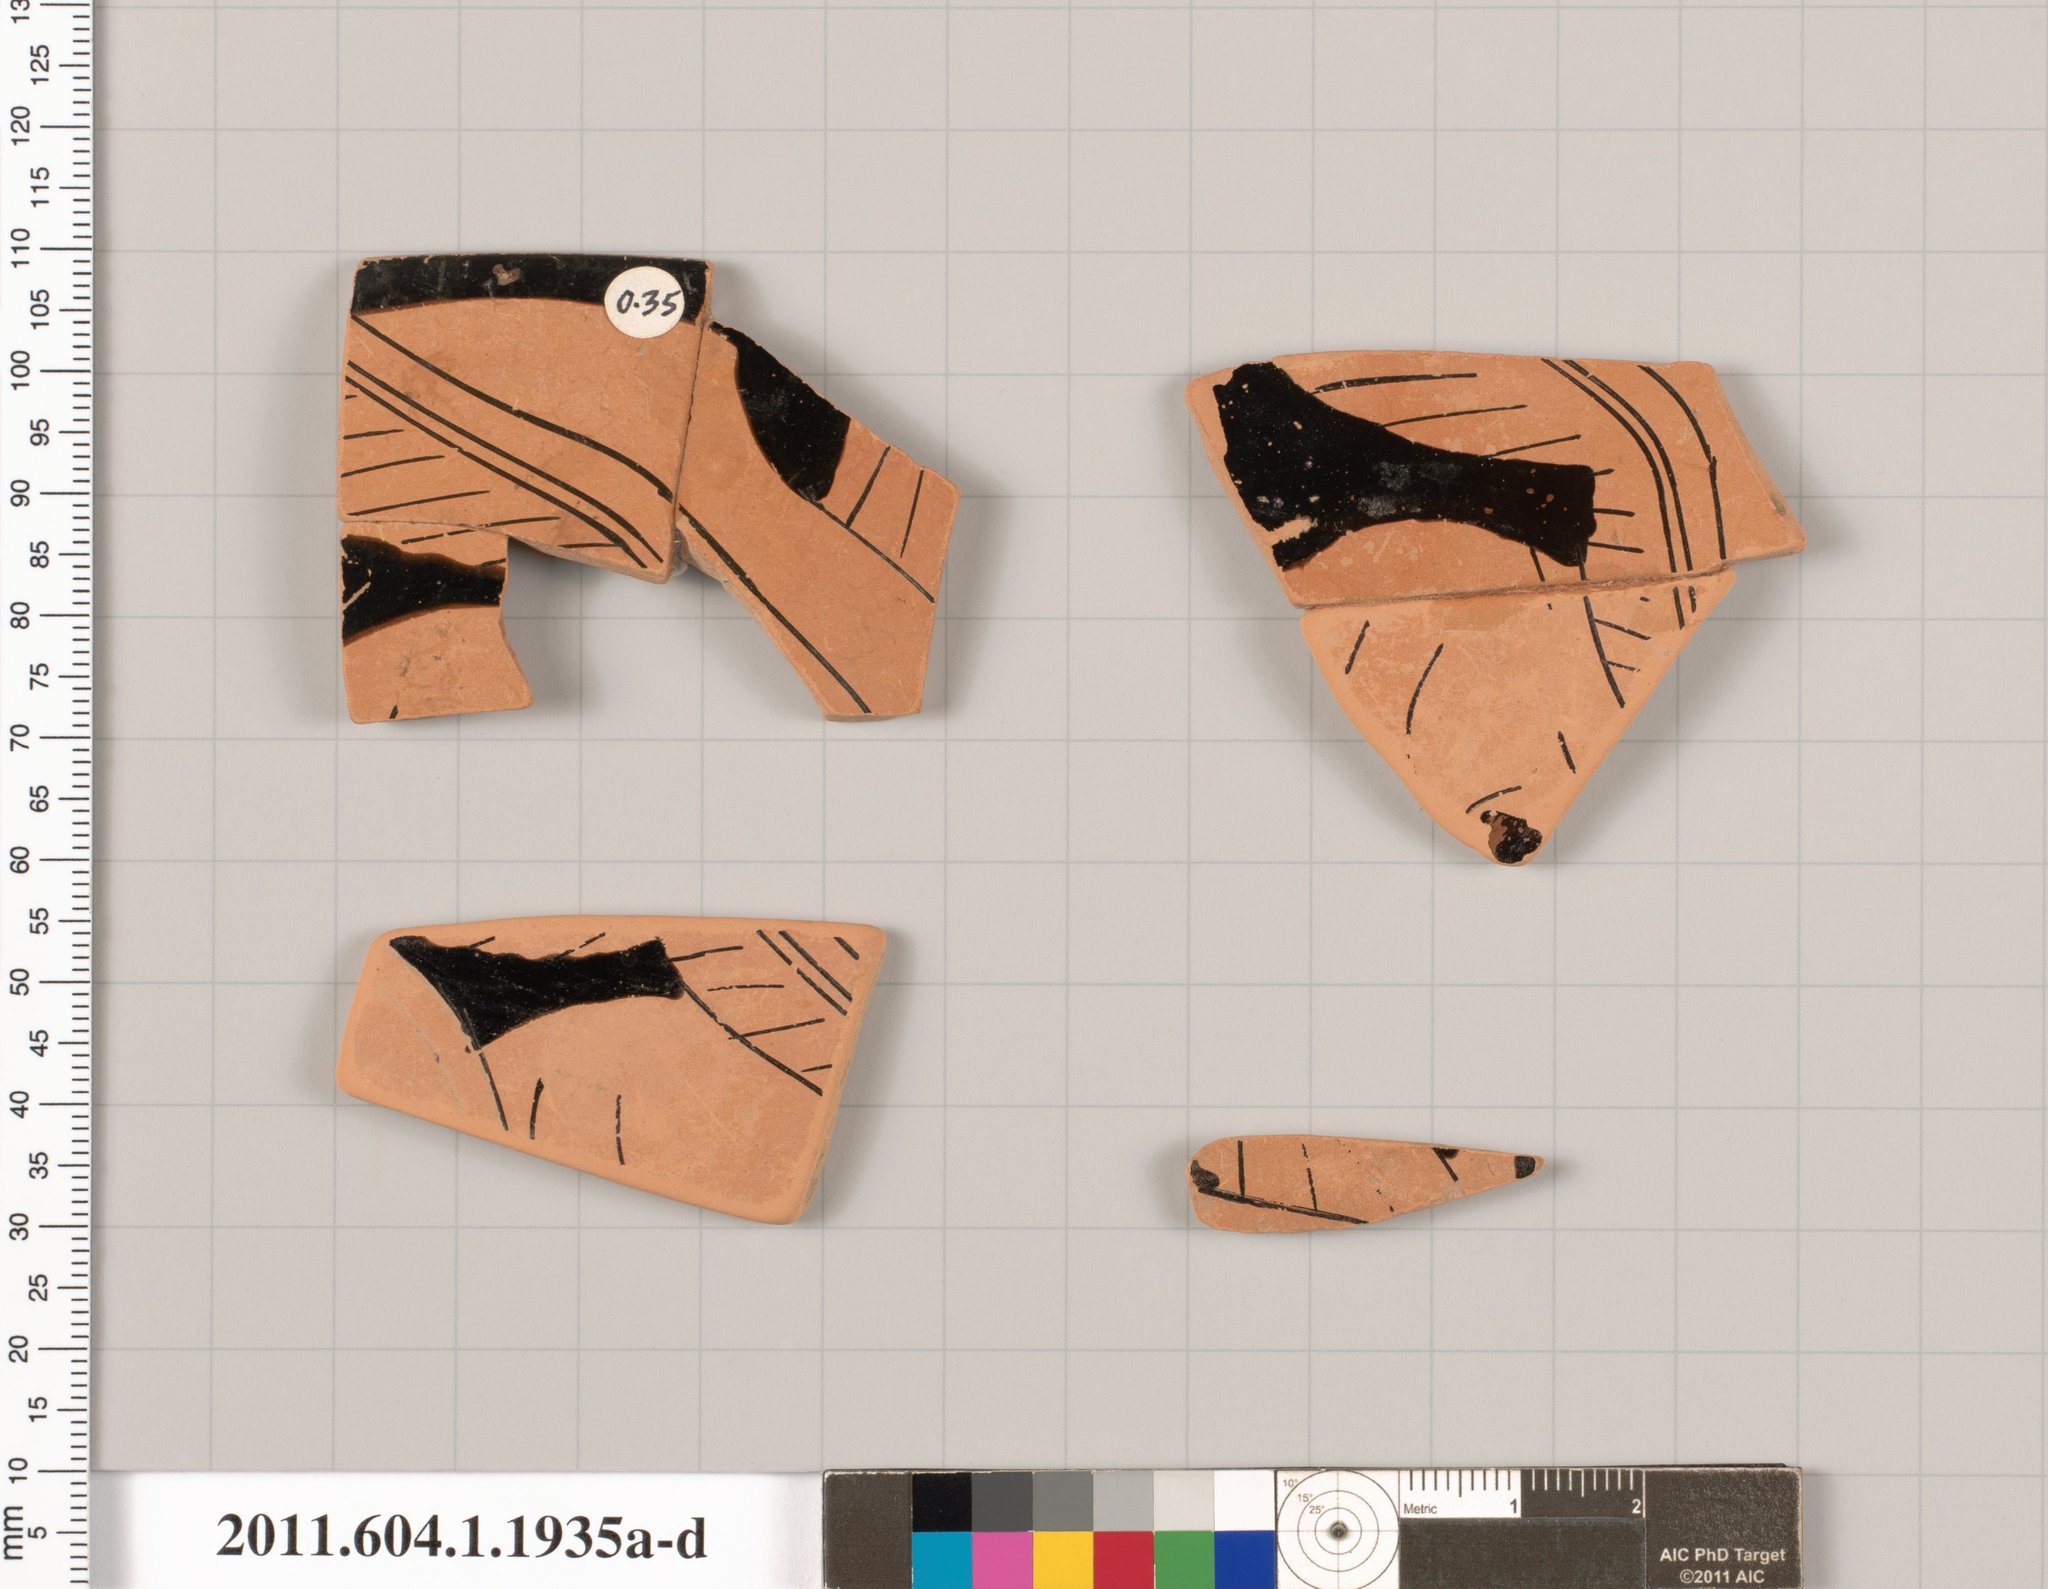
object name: kylix fragment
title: Terracotta fragments of a kylix (drinking cup)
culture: greek, attic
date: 534-501 BCE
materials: terracotta